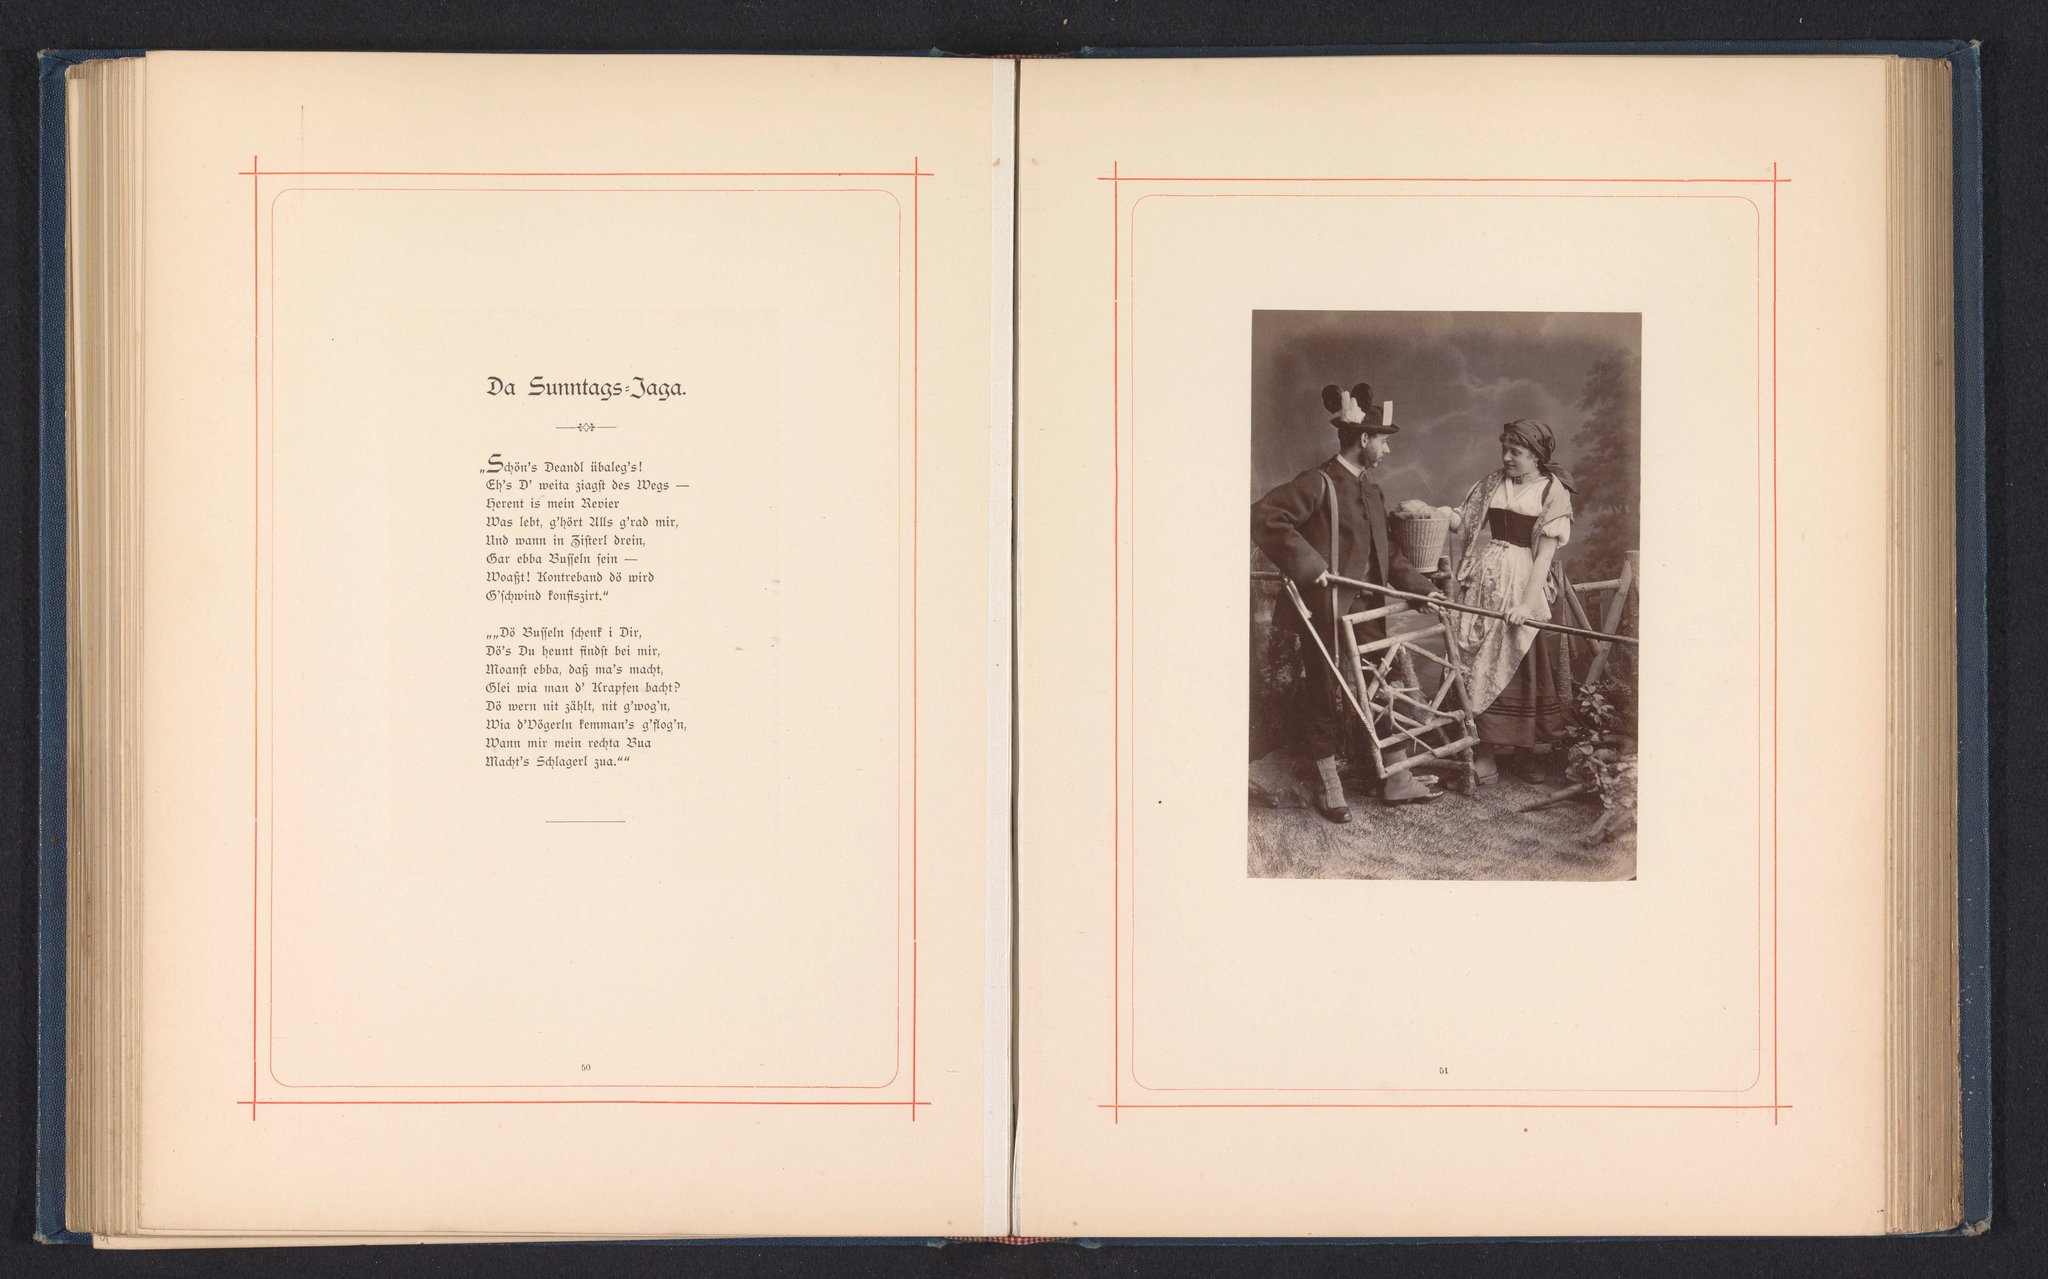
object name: page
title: Man en een vrouw in klederdracht bij een hek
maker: max balde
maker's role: fotograaf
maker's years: 1844-1900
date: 1877-1882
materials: photographic support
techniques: albumen print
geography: salzburg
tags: adult woman, fence, wall, paling, adult man, folk costume, regional costume